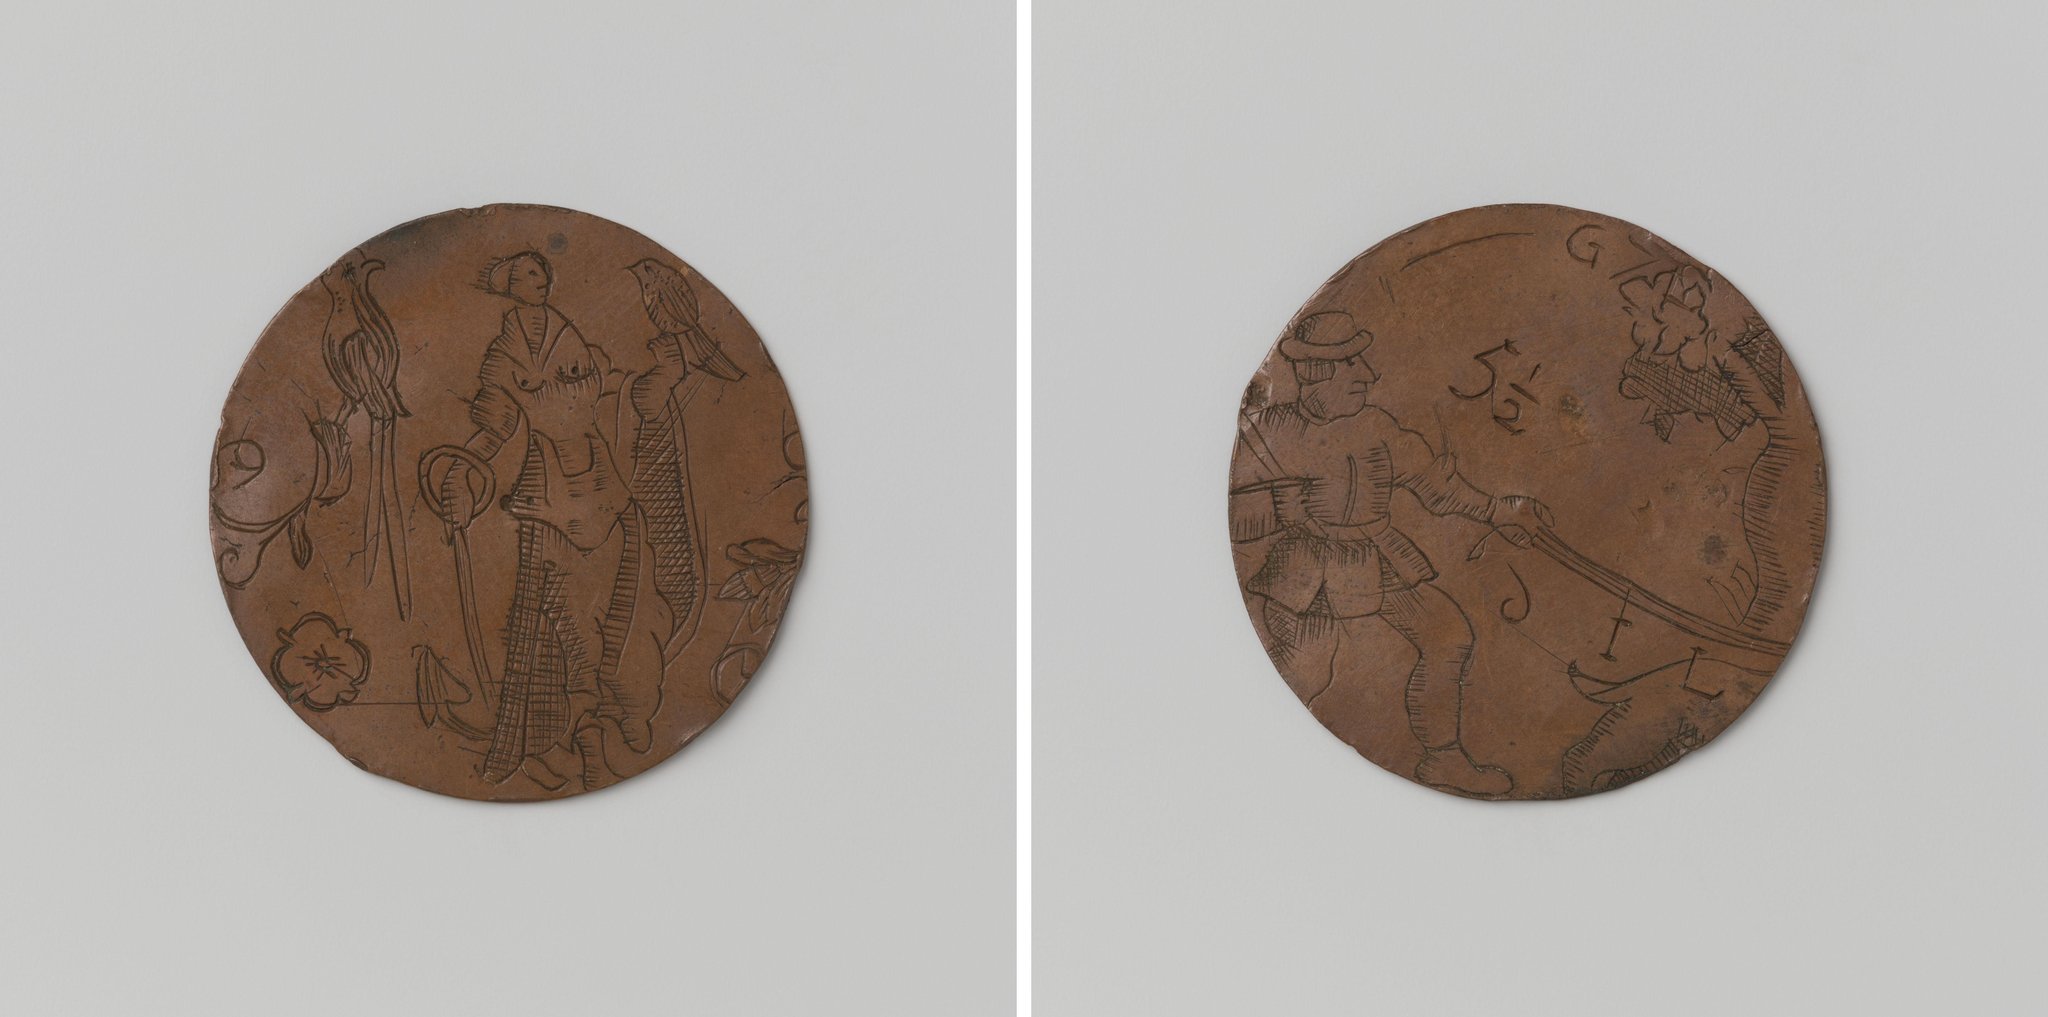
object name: medal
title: Penning van koper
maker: Anonymous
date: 1600-1700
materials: copper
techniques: engraving